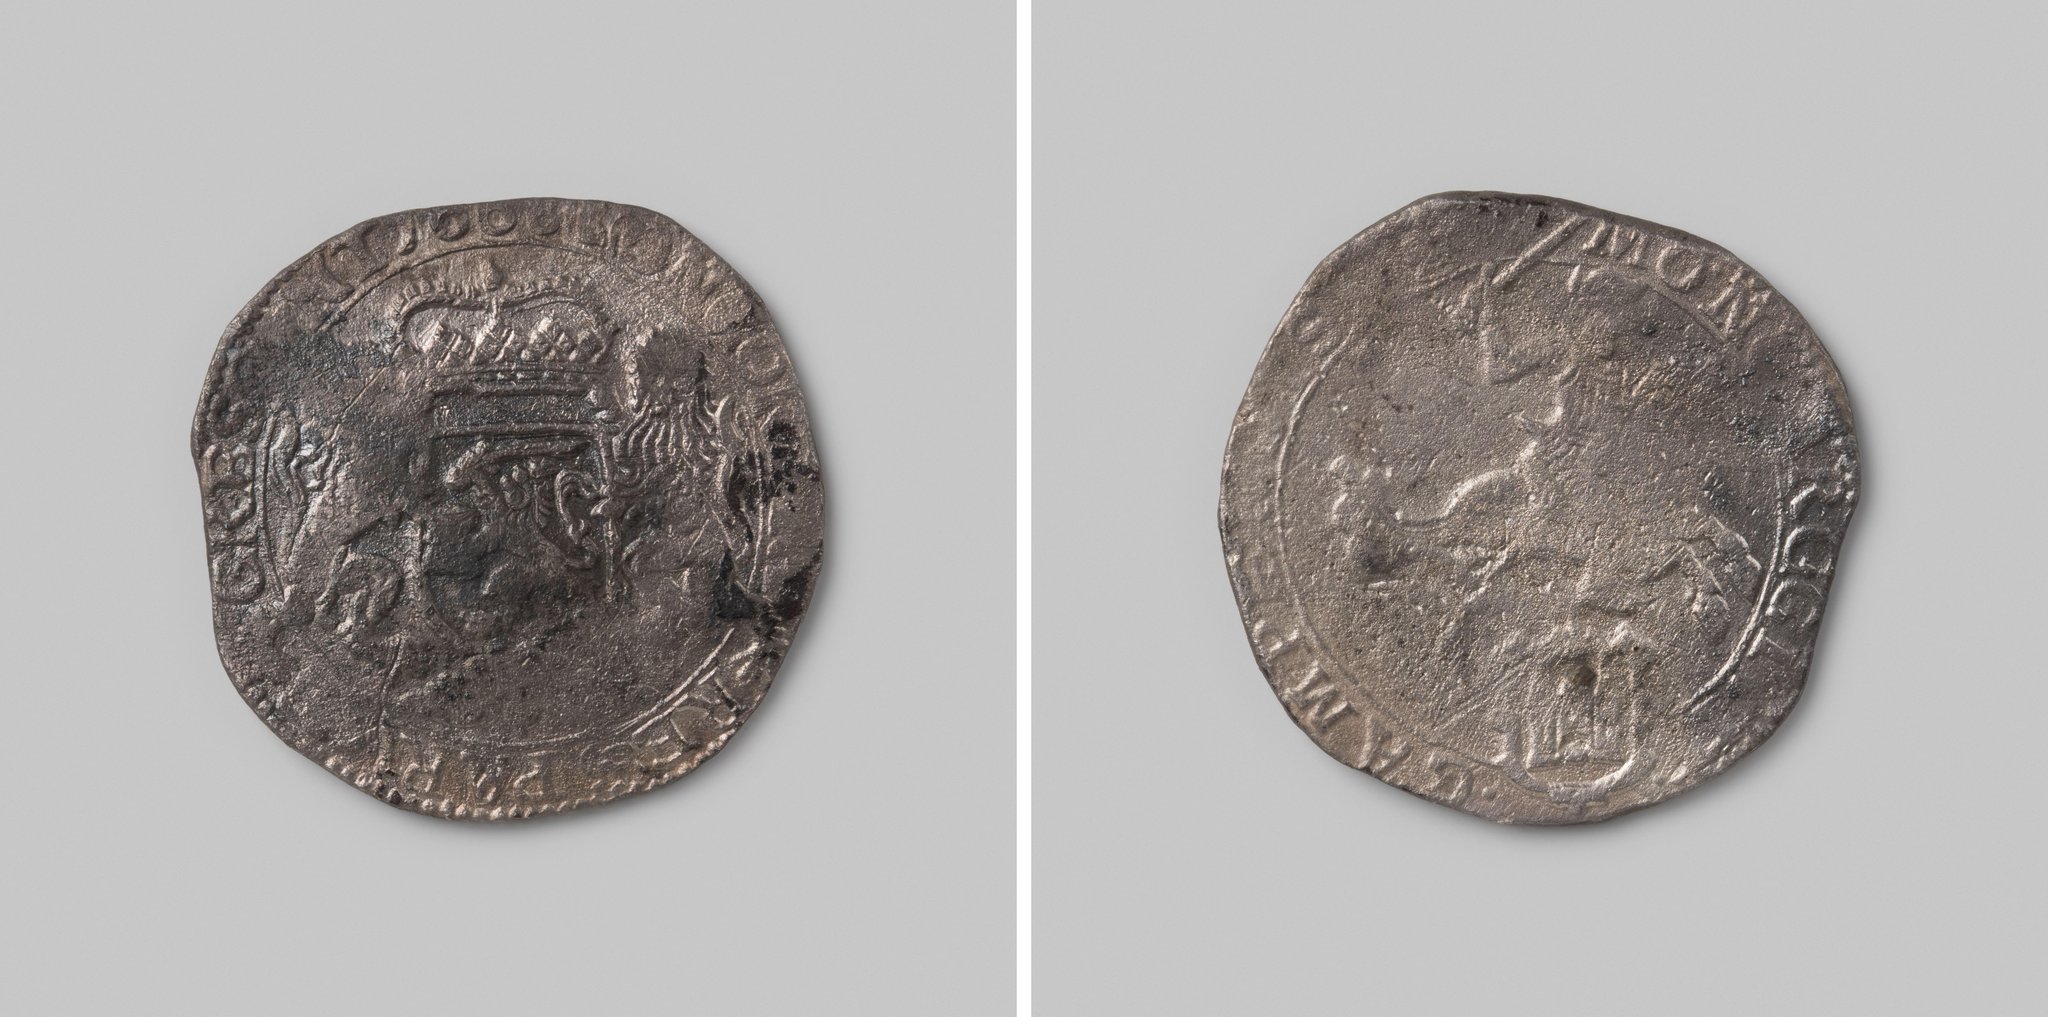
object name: coin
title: Zilveren rijder van Kampen, uit het wrak van de Oost-Indiëvaarder Hollandia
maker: Anonymous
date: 1659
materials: silver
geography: kampen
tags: verenigde oostindische compagnie, hollandia (schip), annet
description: Economic objects, coin, silver rider (1) circular, irregular rim (c.4.2d, 0.25t, 29.93gr); Kampen 1659, obverse and reverse type id. NG 1975-58H, coin.